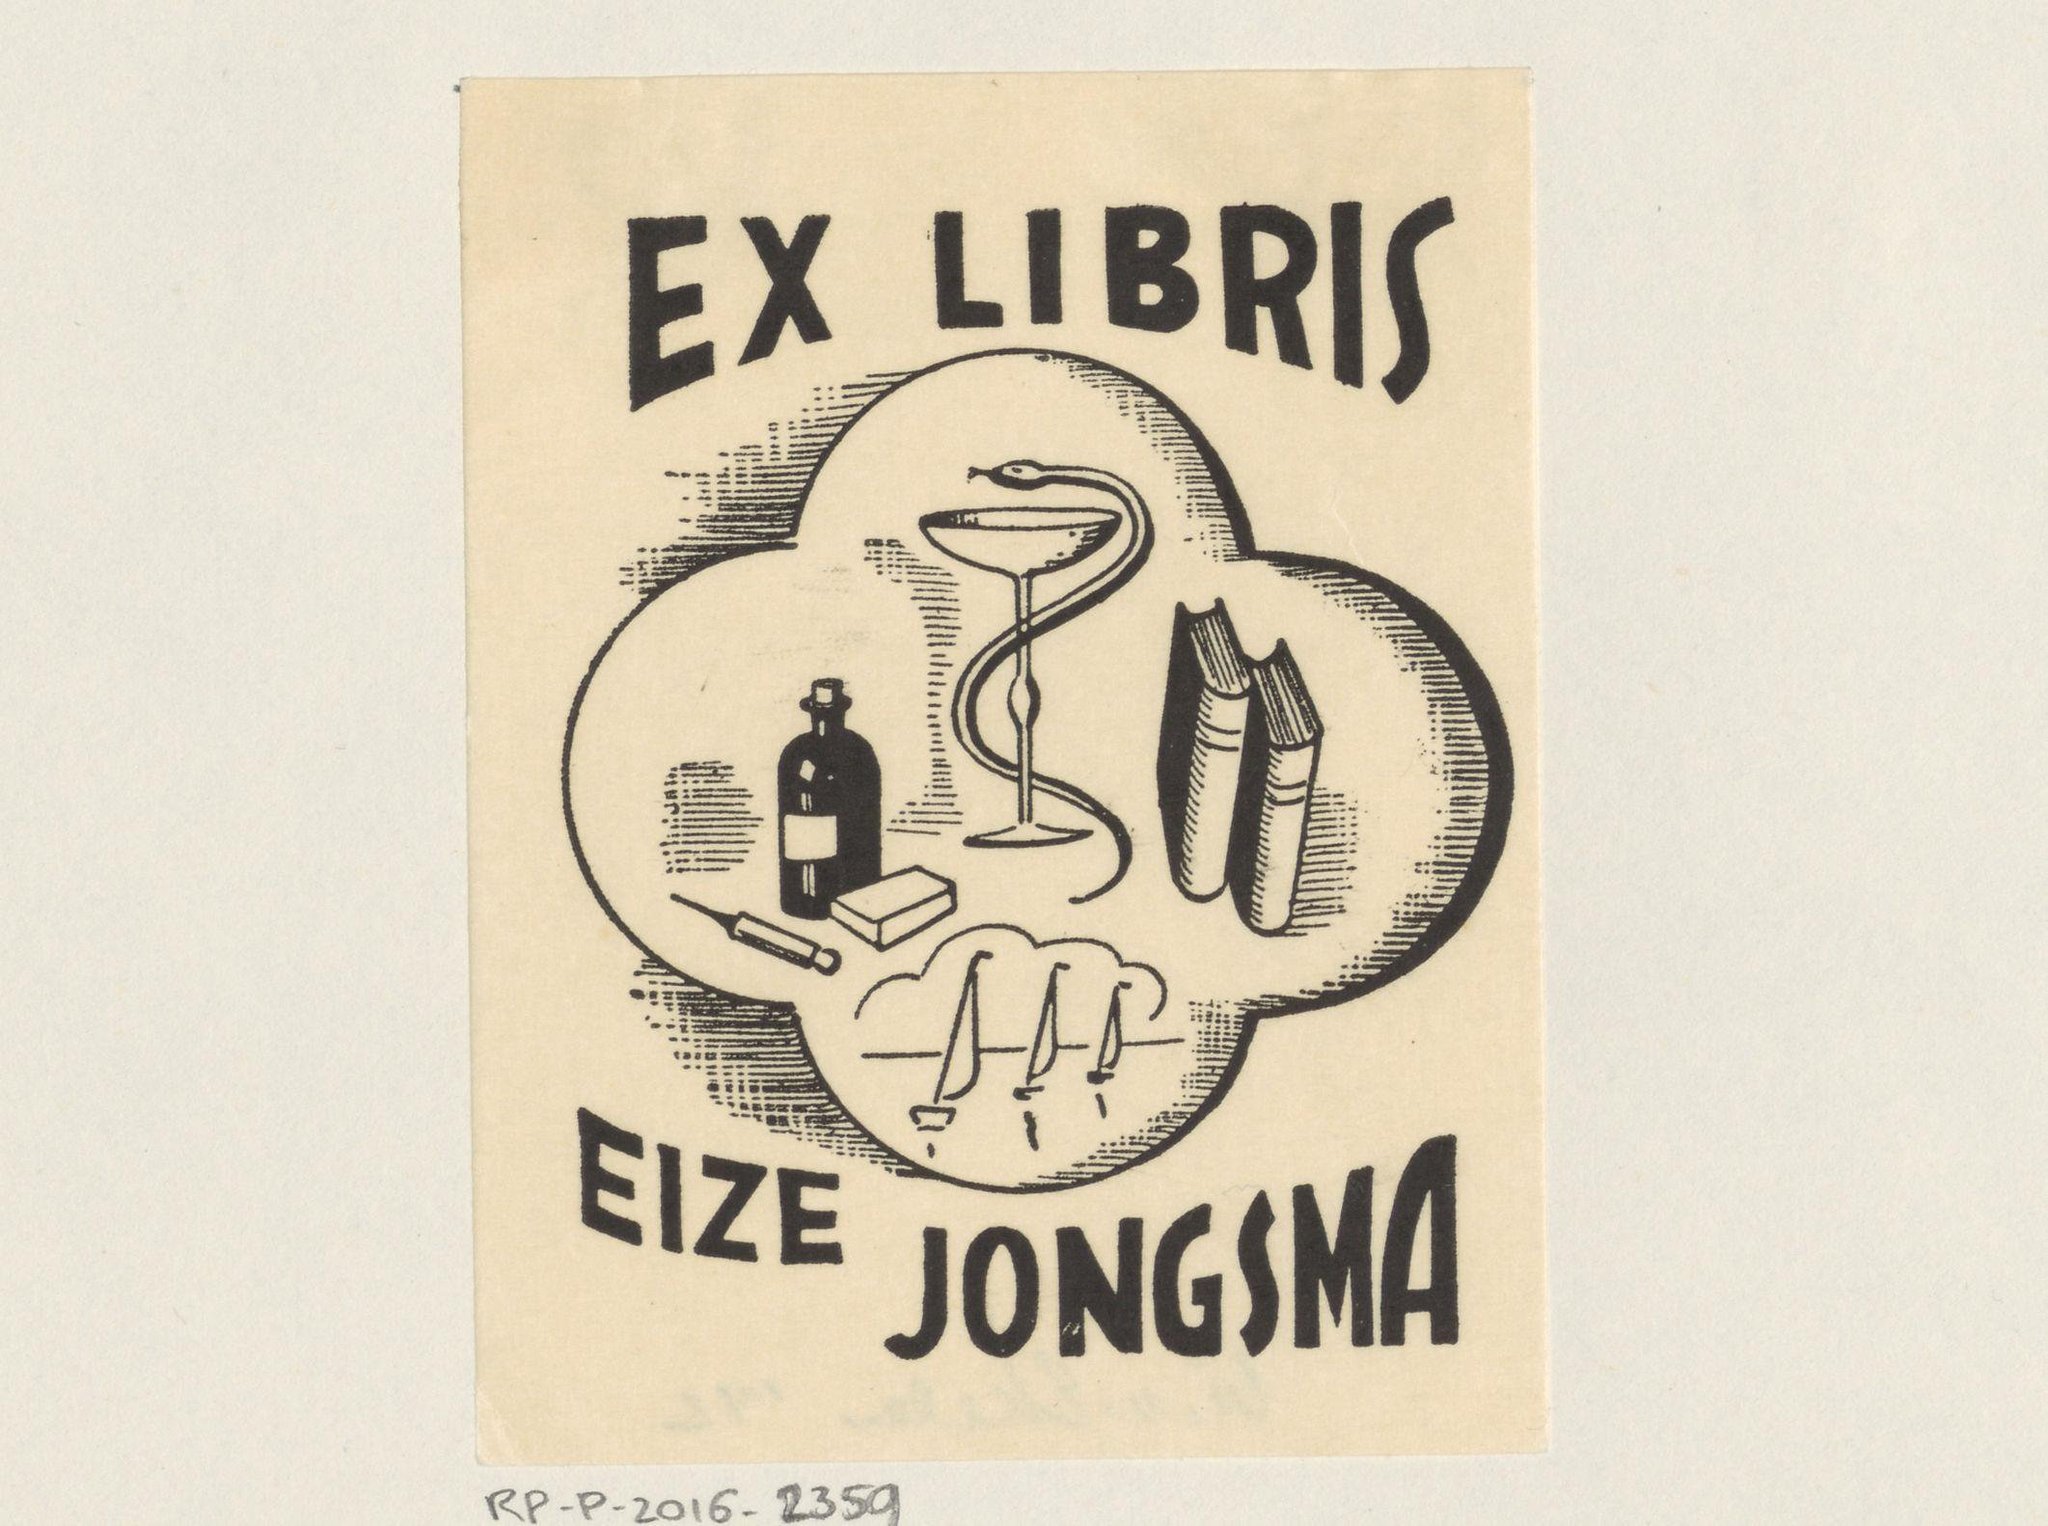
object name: bookplate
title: Ex libris van Eize Jongsma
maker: w.r.a. van ekelen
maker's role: painter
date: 1942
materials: paper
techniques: printing block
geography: netherlands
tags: sailing-ship, sailing-boat, medicine, medical science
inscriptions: inscription: ‘W. v. Ekelen '42’